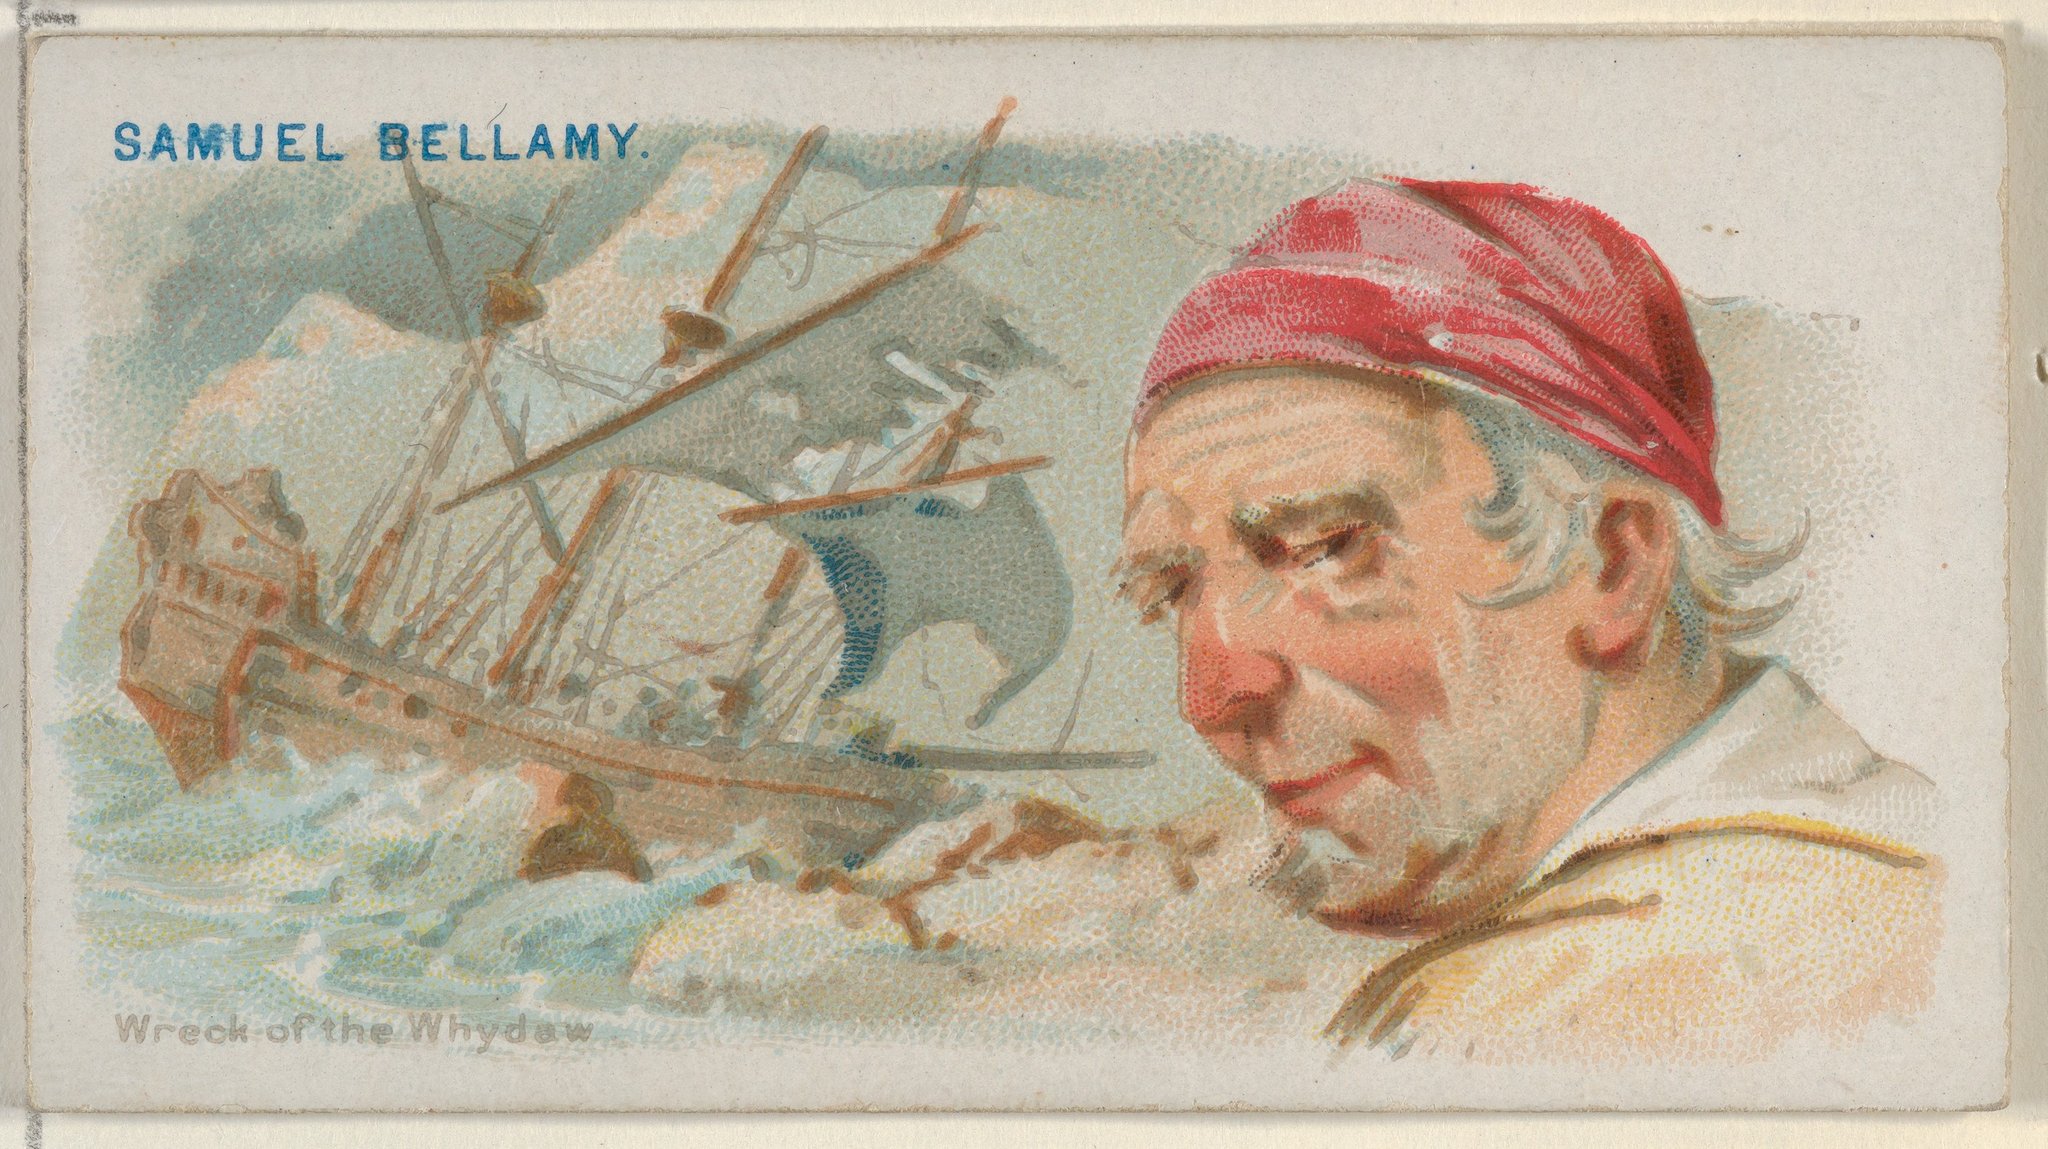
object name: print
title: Samuel Bellamy, Wreck of the Whydah, from the Pirates of the Spanish Main series (N19) for Allen & Ginter Cigarettes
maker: allen & ginter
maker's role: publisher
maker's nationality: american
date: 1888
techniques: color lithograph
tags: men,ships